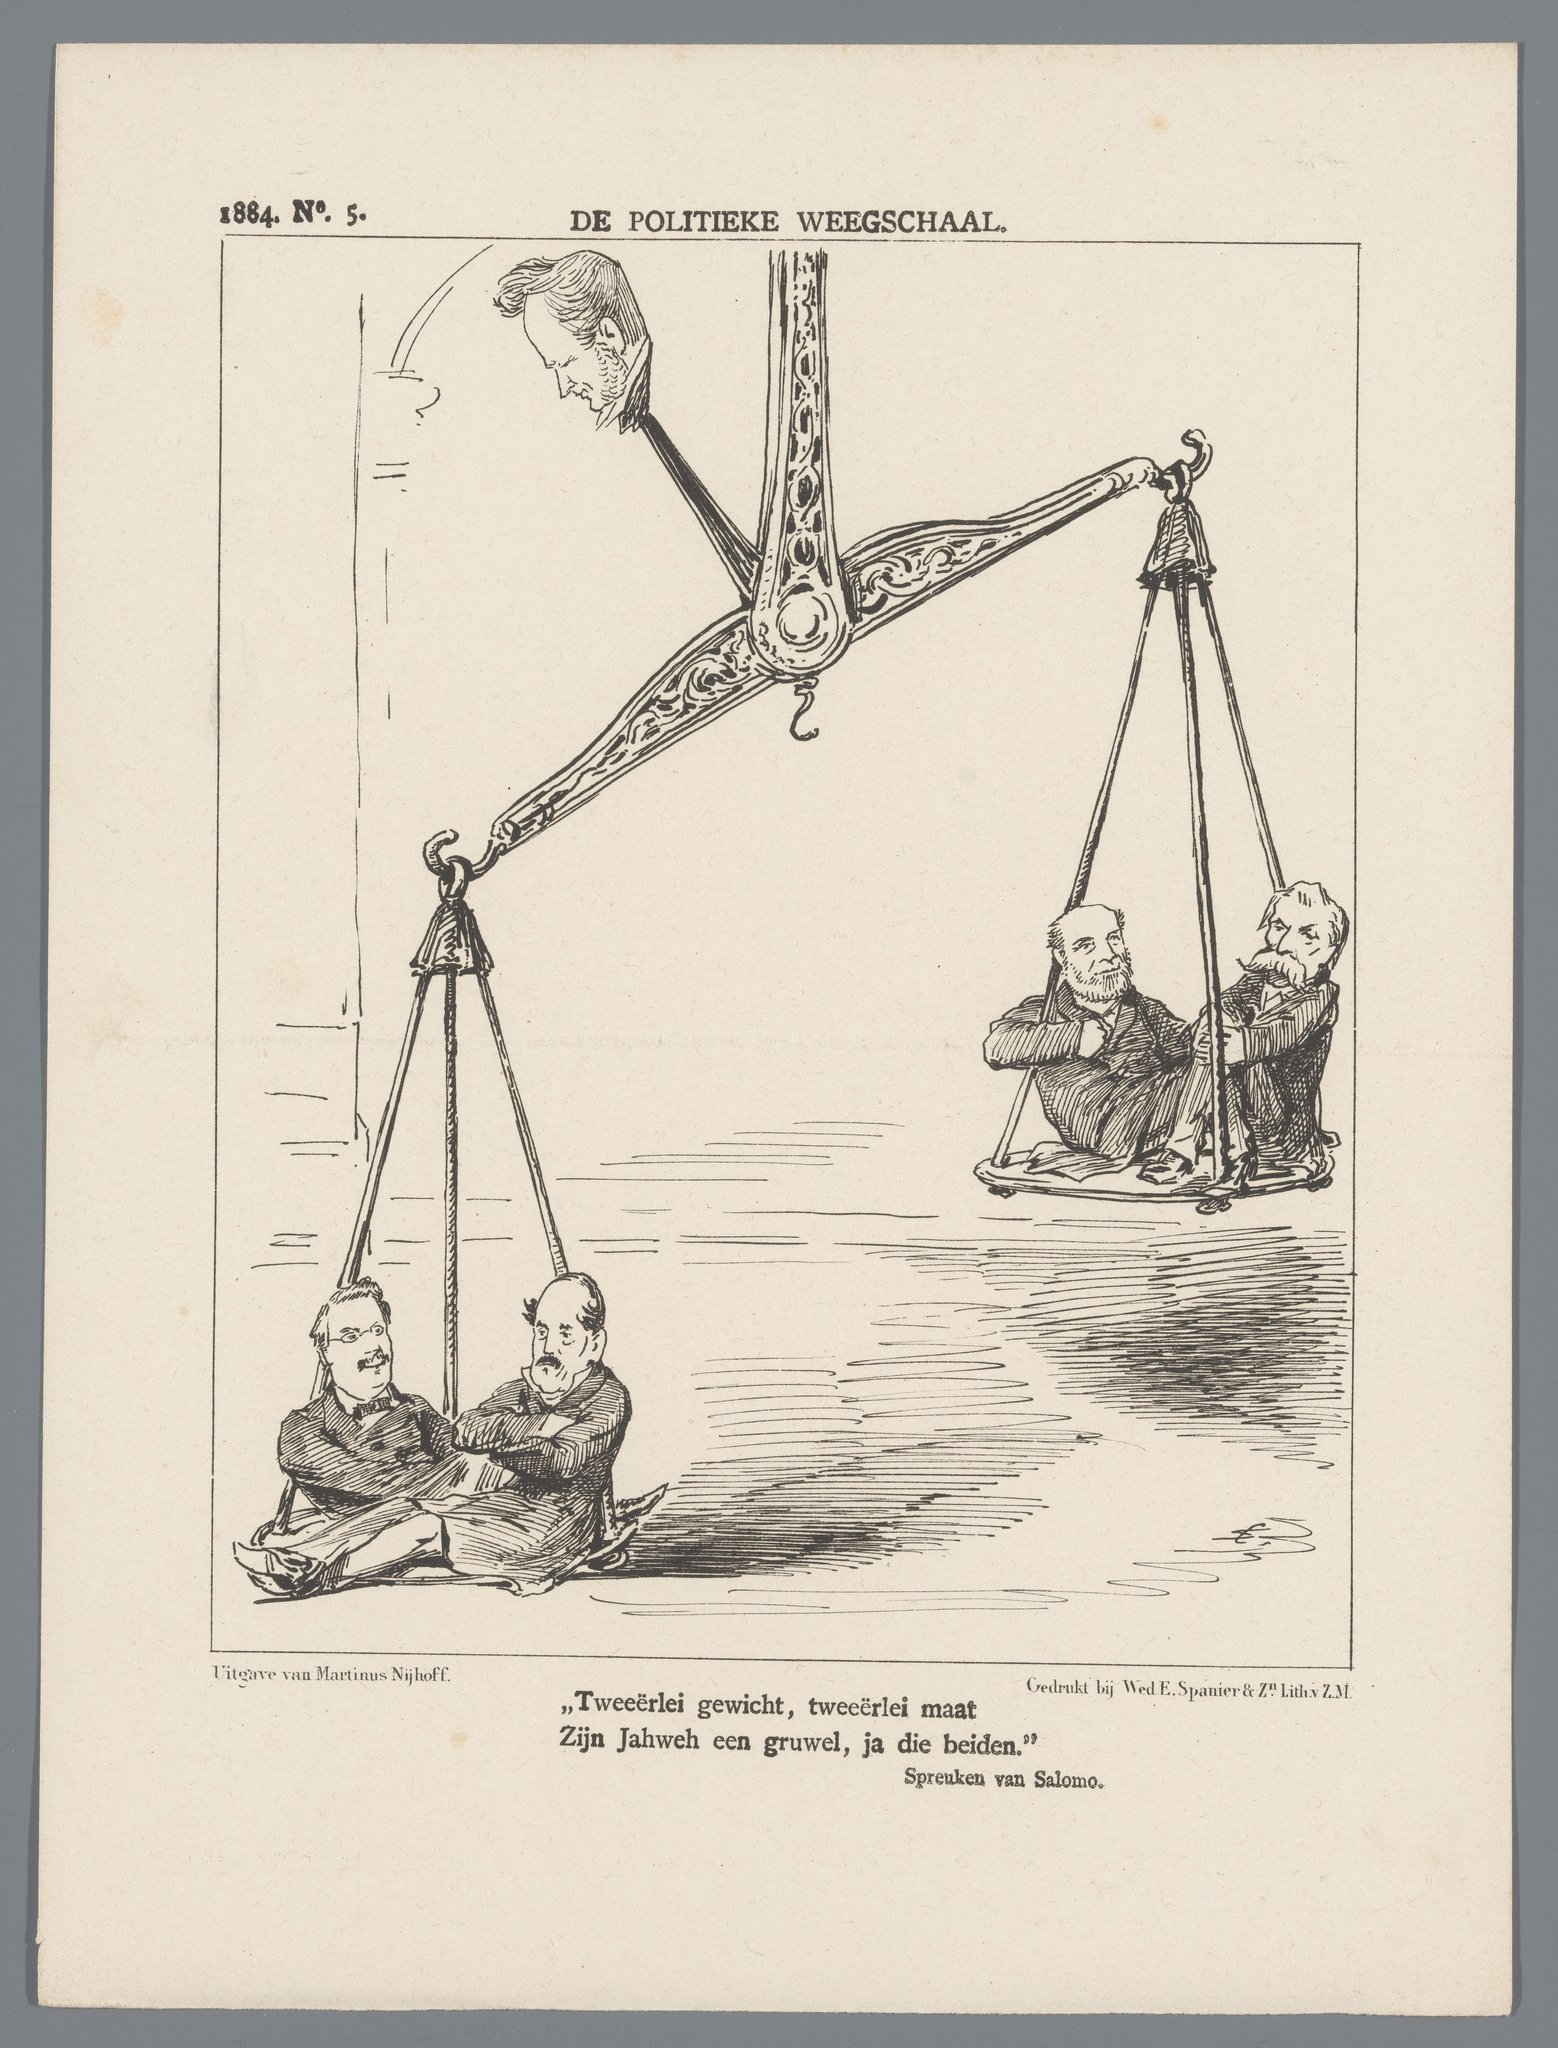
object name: cartoon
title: De politieke weegschaal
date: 1884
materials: paper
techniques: lithograph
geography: netherlands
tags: amsterdam, the hague, politician, scales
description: Spotprent met ministers op de weegschaal van Minister Heemskerk. Plaat verschenen bij het weekblad De Nederlandsche Spectator, nr. 5, 1884.